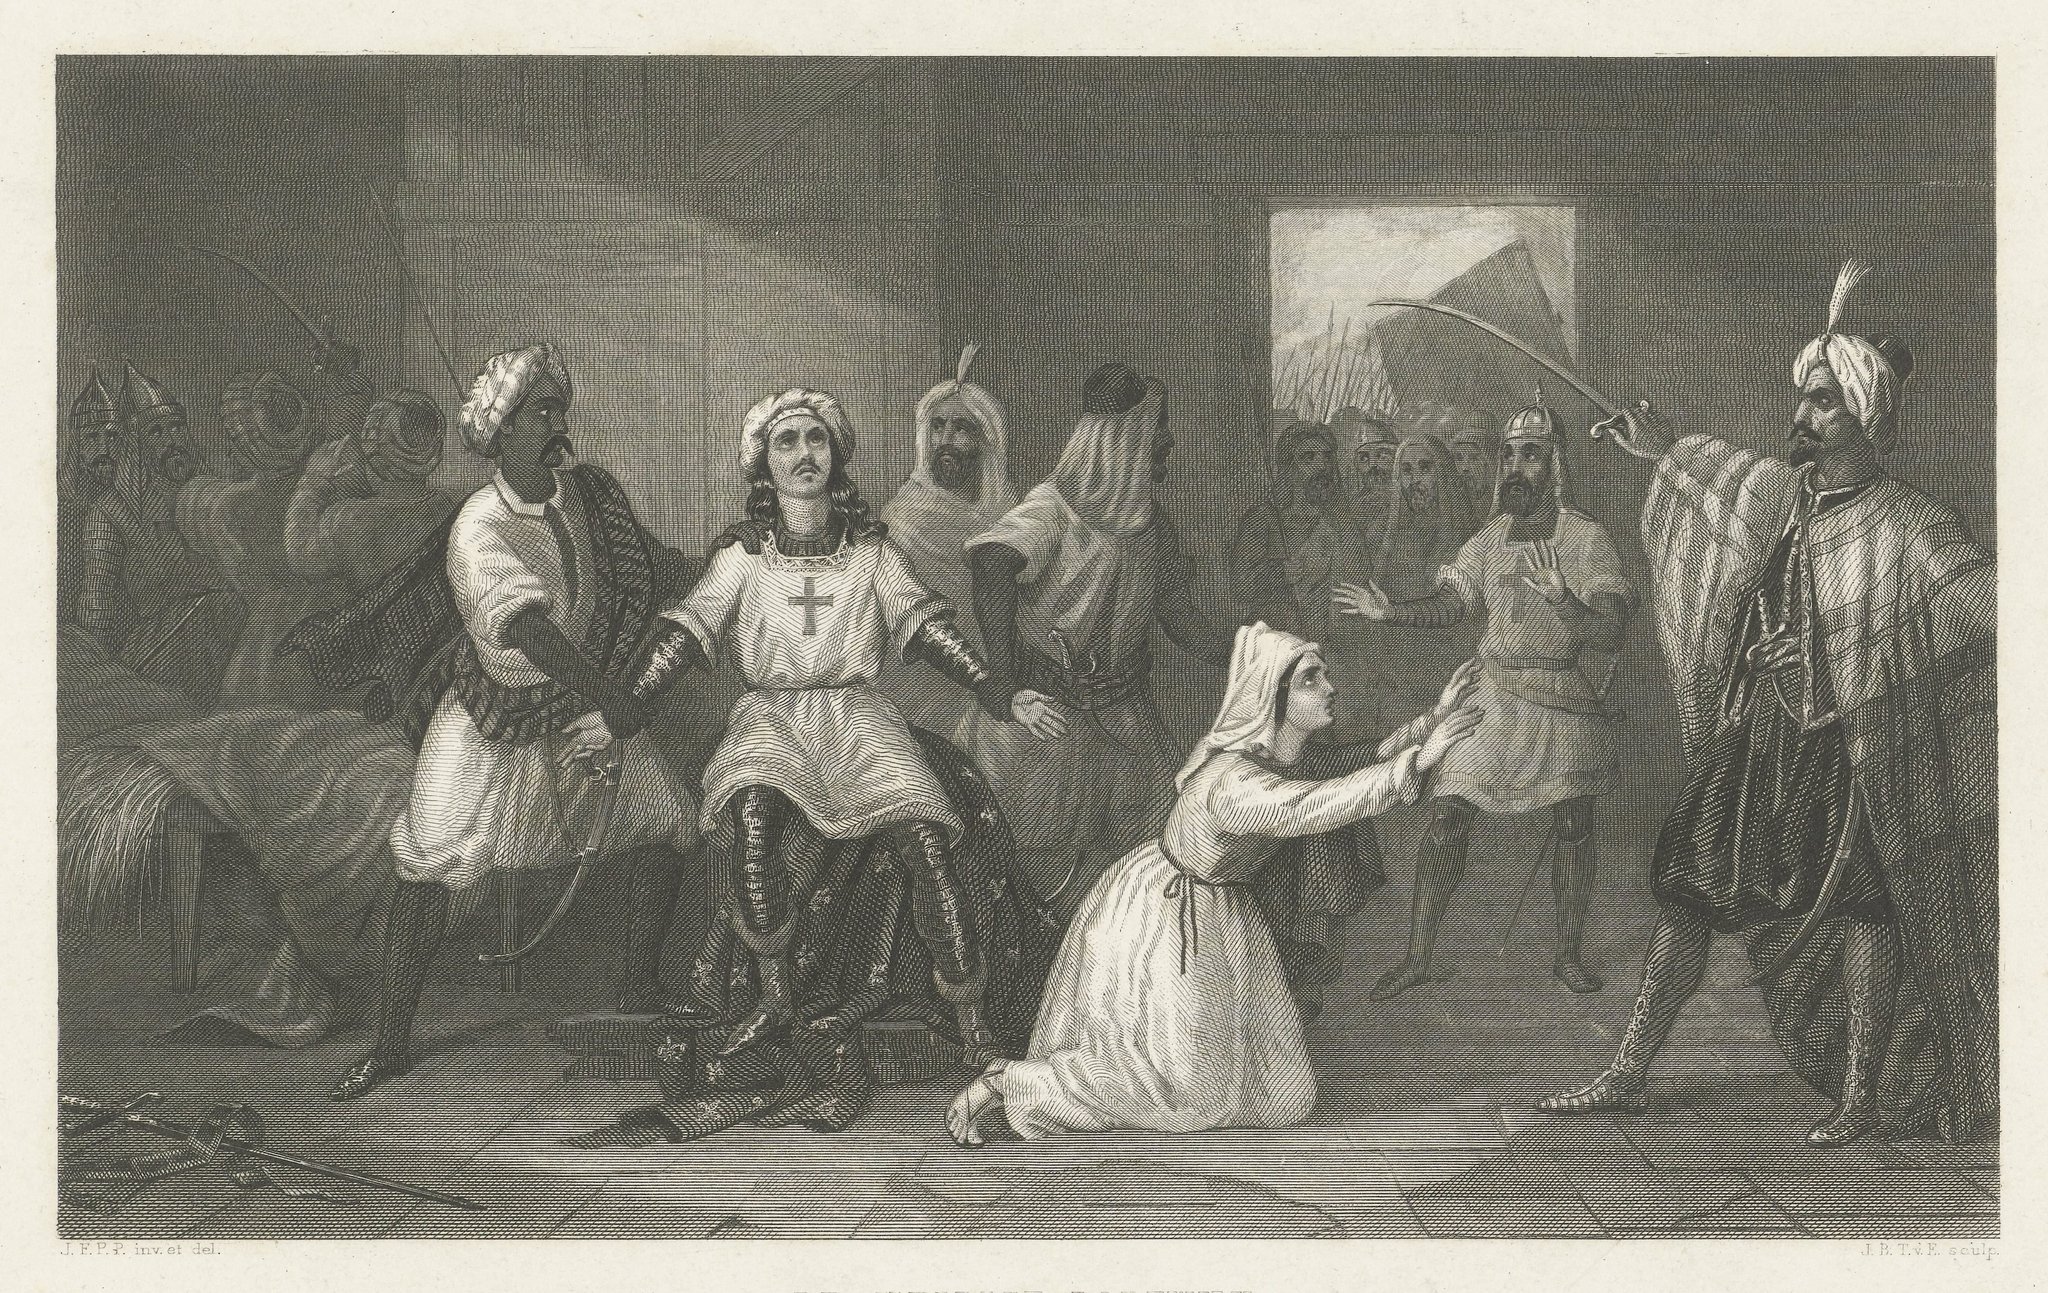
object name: print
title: Lodewijk IX tijdens een kruisvaart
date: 1815-1889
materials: paper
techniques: engraving, etching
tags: poissy, tunis, koning, lodewijk ix de heilige (koning van frankrijk)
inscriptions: collector's mark: Lugt 2228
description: Lodewijk IX, vastgehouden door een man met een tulband, kijkt met gespreide armen omhoog. Voor hem steekt een geknielde vrouw haar armen uit naar een man met getrokken sabel. Op de achtergrond worden kruisvaarders door tegenstanders tegengehouden.